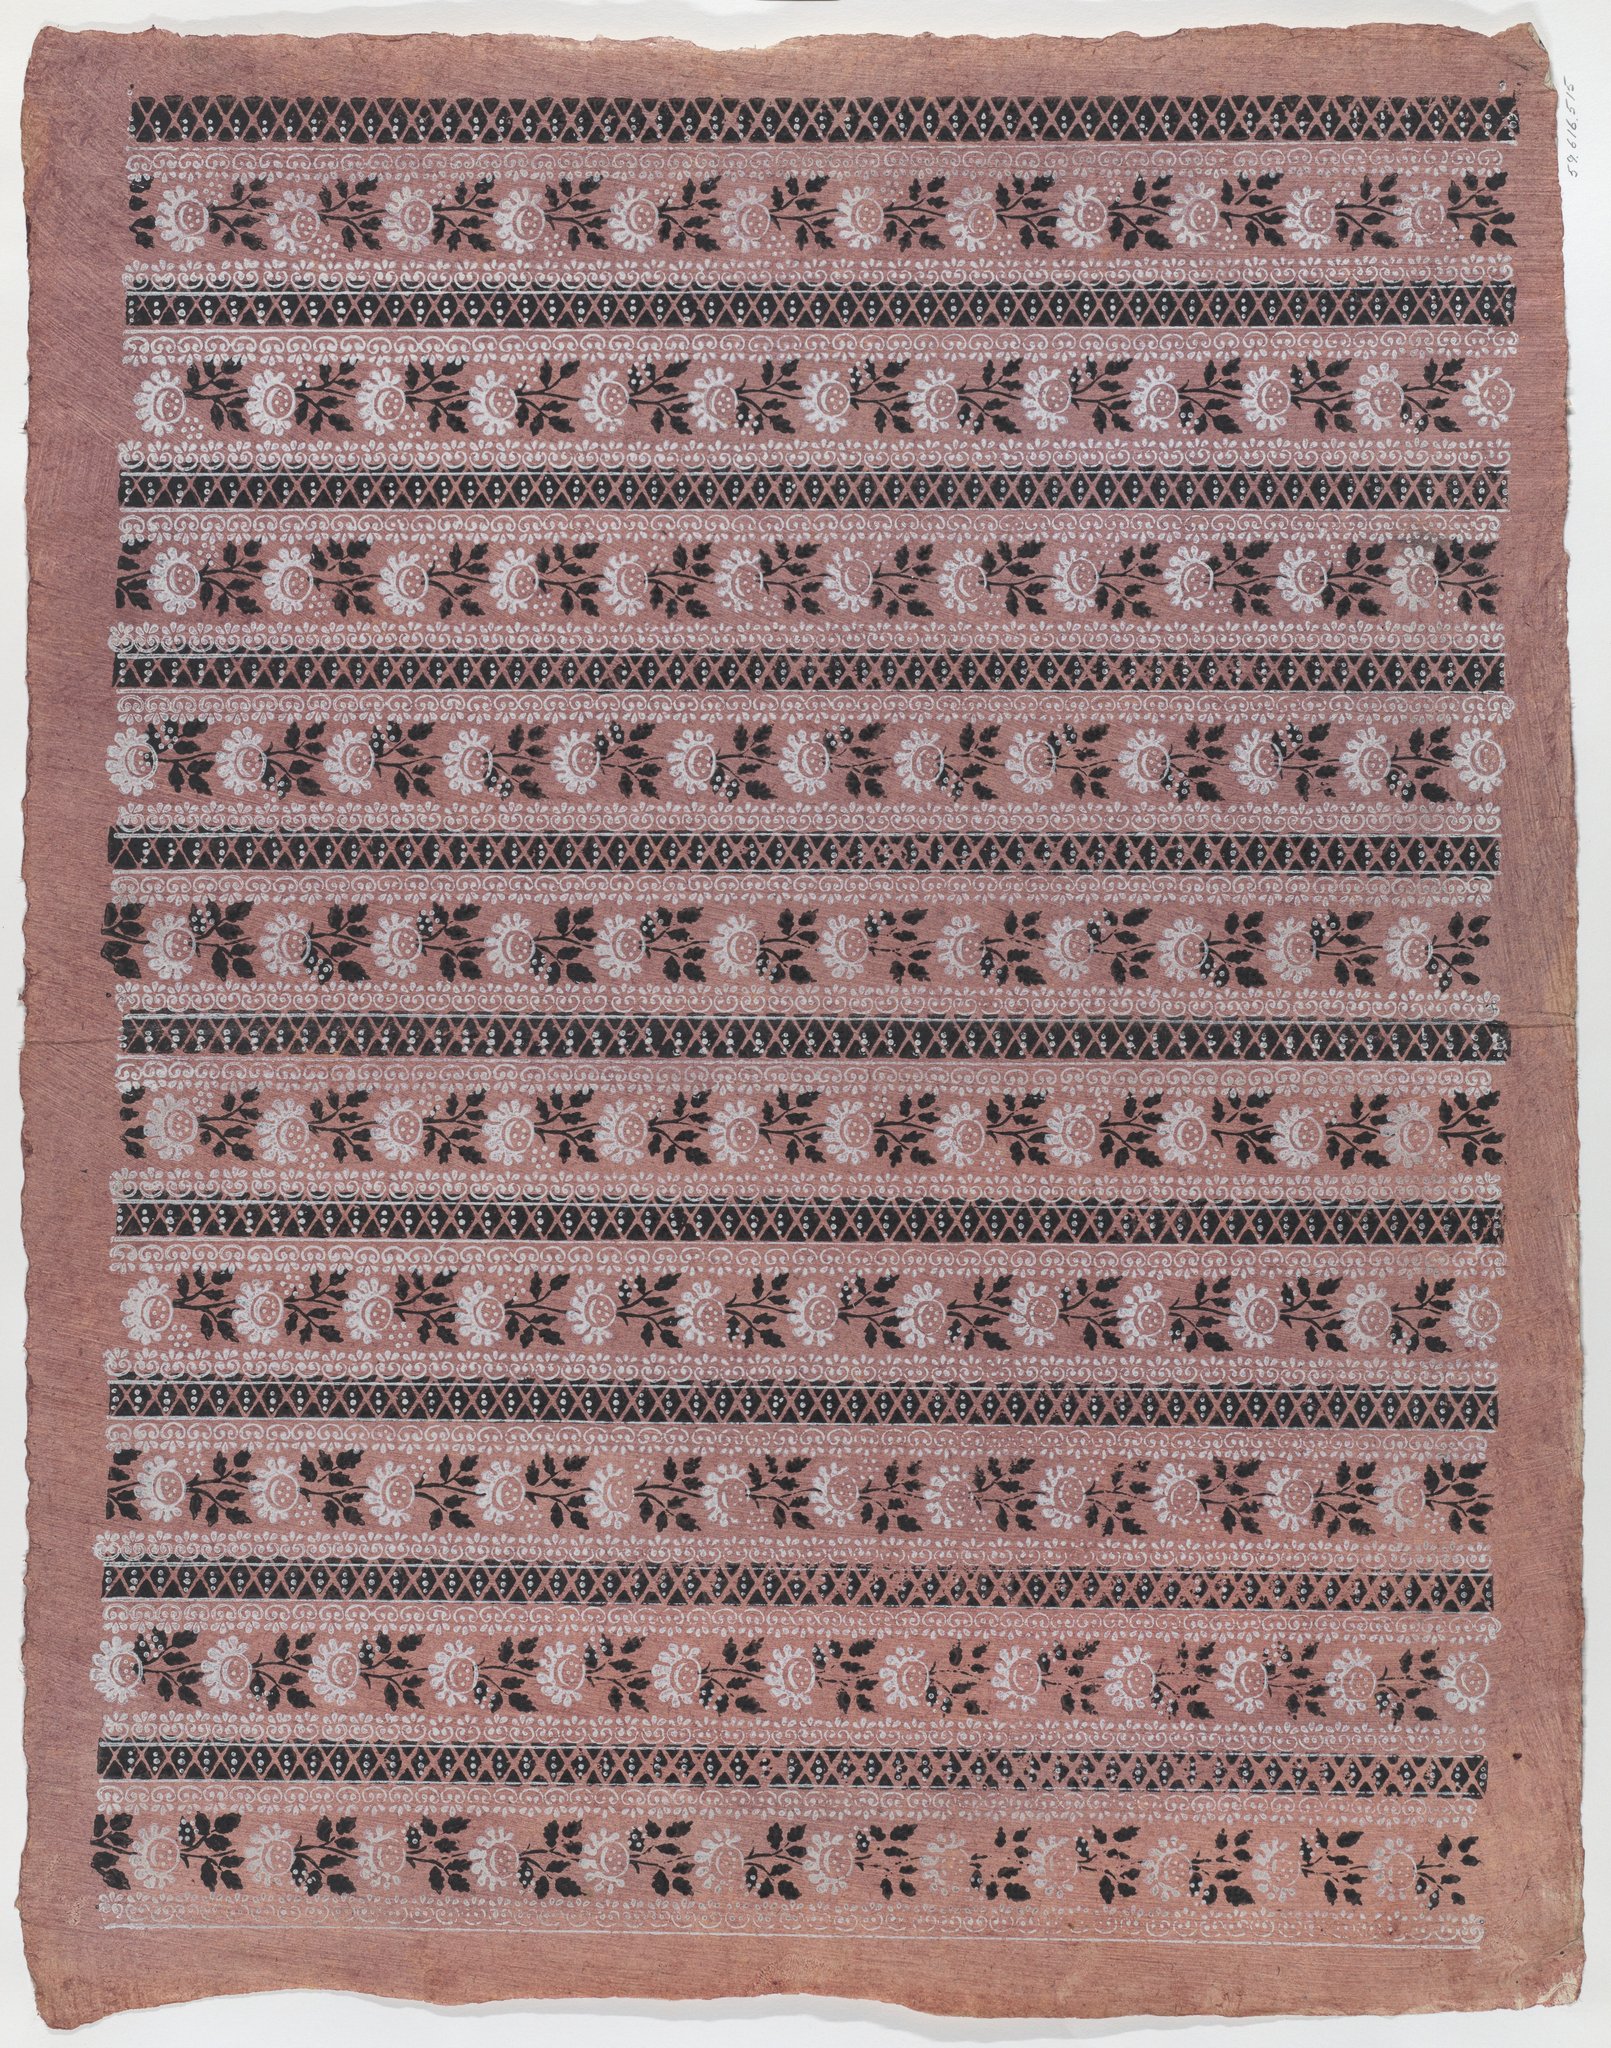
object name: print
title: Sheet with ten borders with floral patterns on pale pink background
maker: Anonymous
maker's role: artist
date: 1767-1866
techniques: relief print